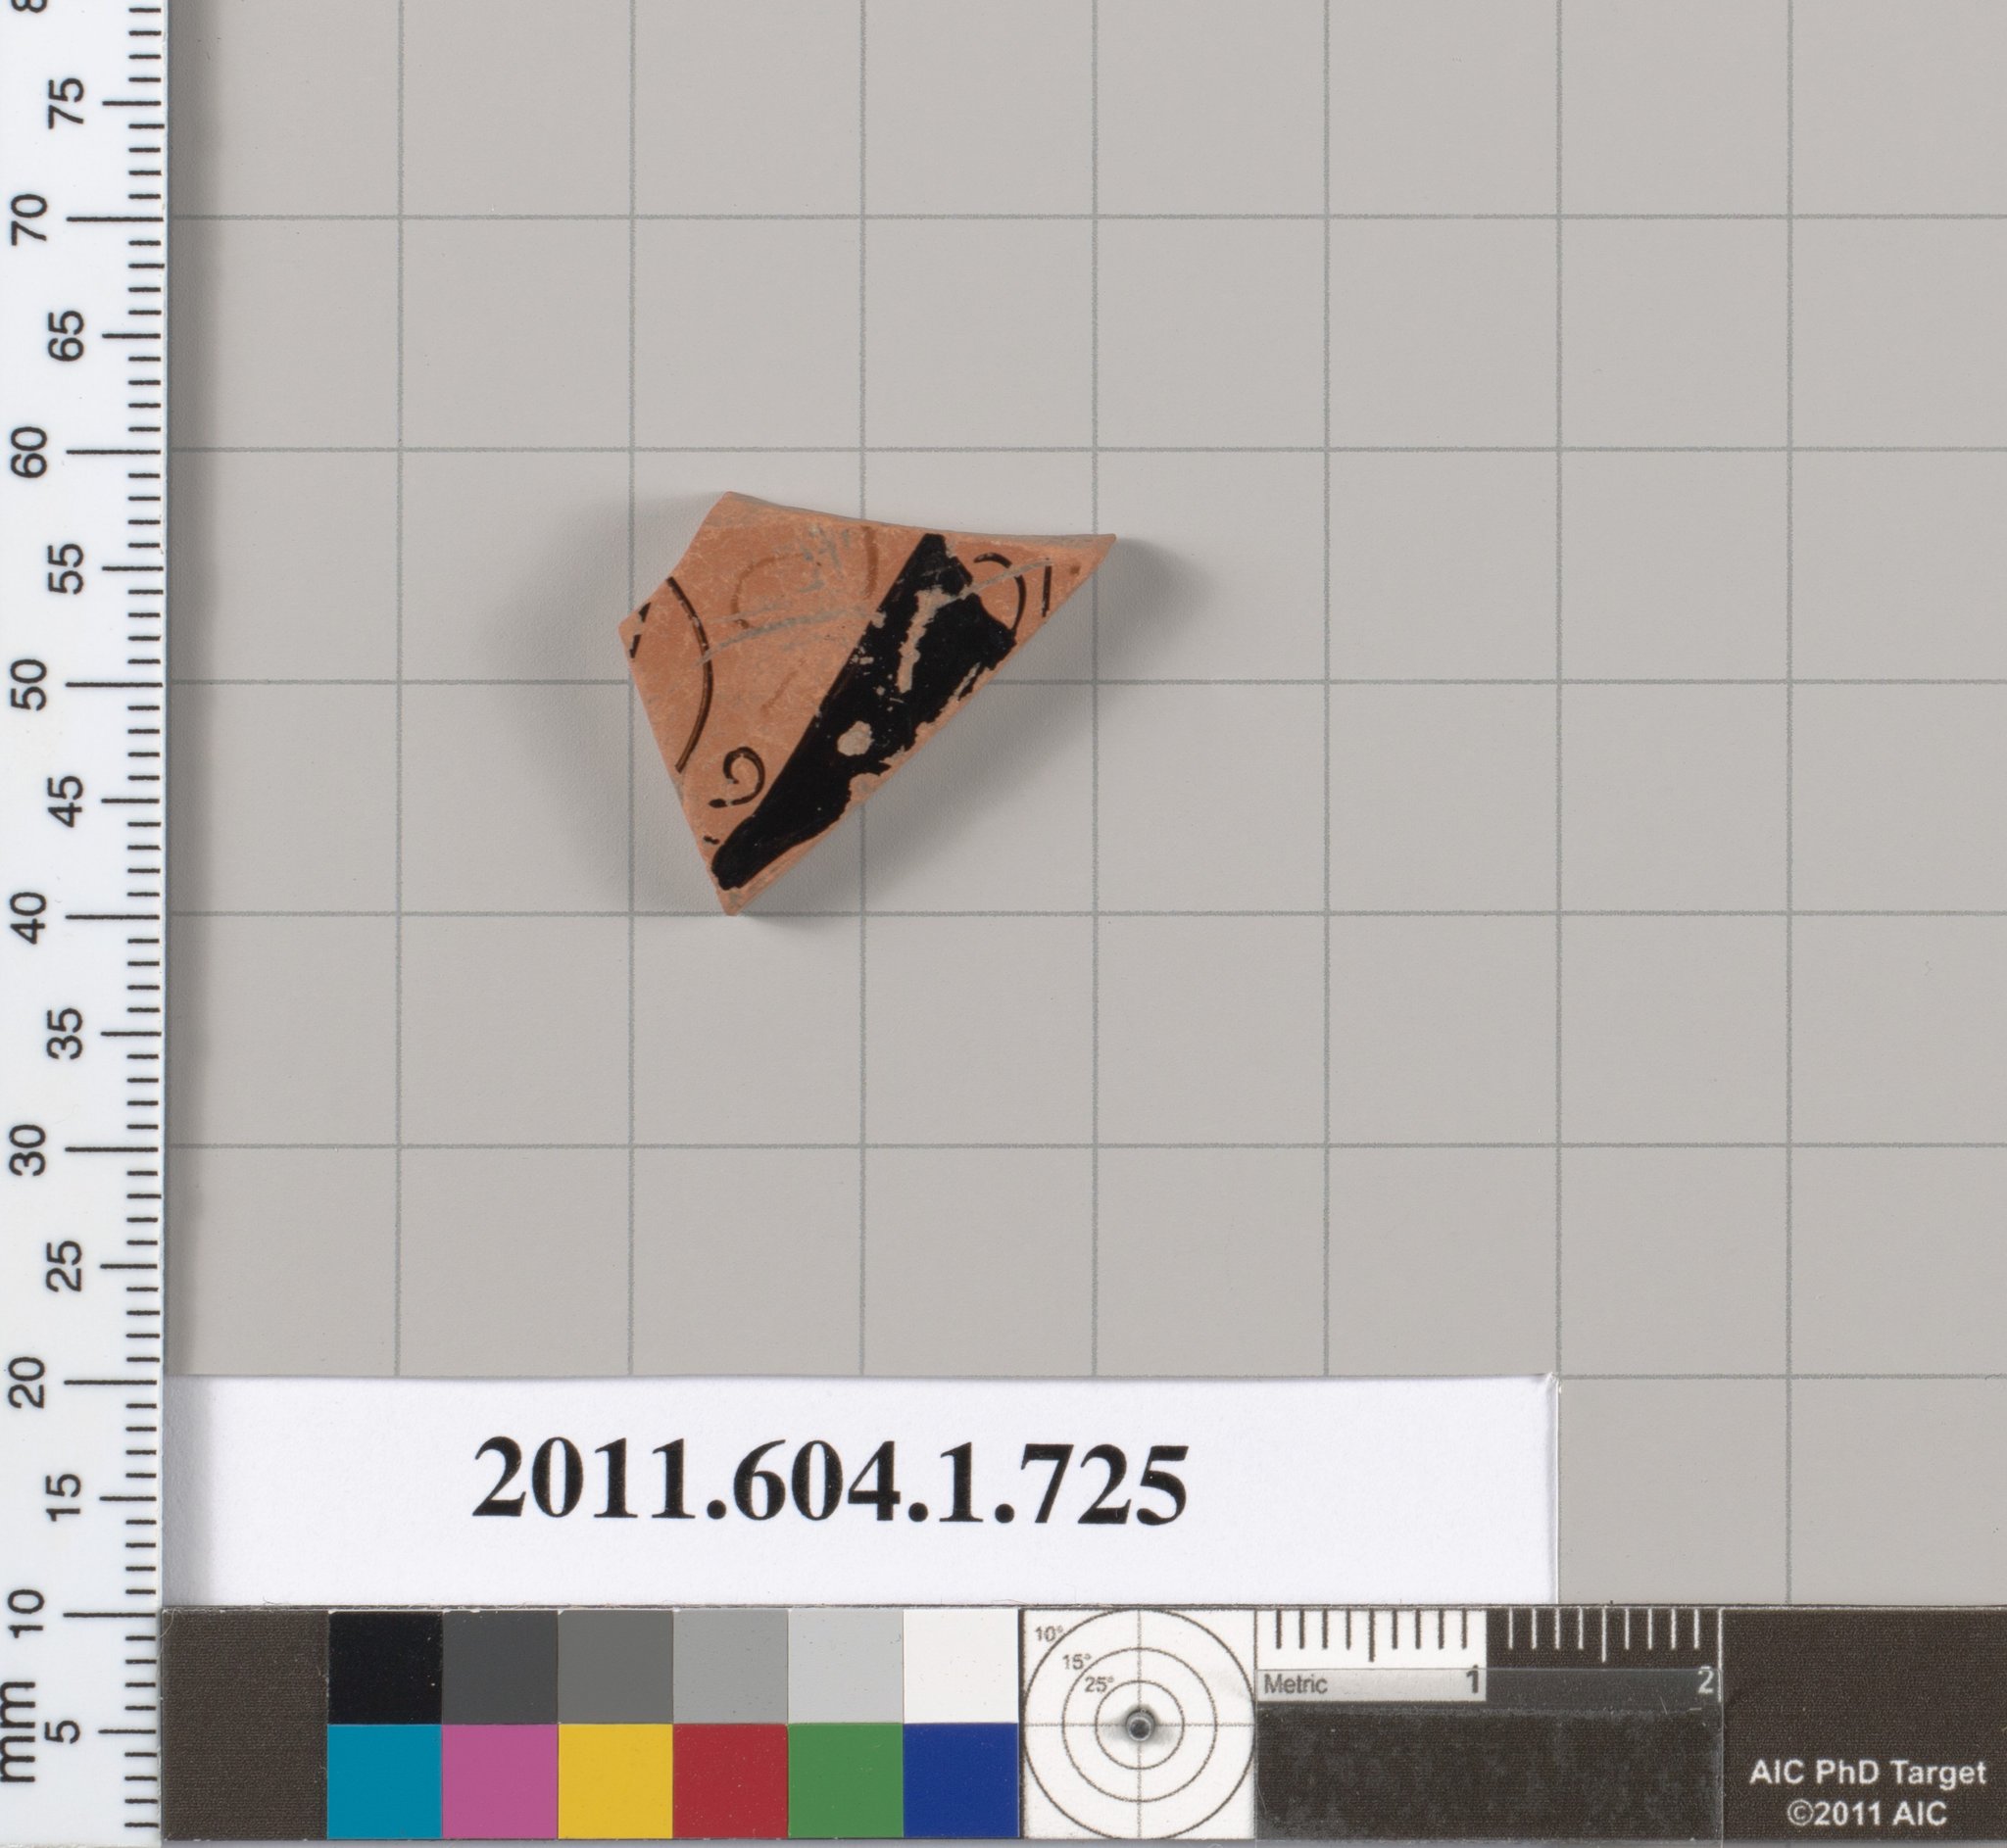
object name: kylix fragment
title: Terracotta fragment of a kylix (drinking cup)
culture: greek, attic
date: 475-451 BCE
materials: terracotta